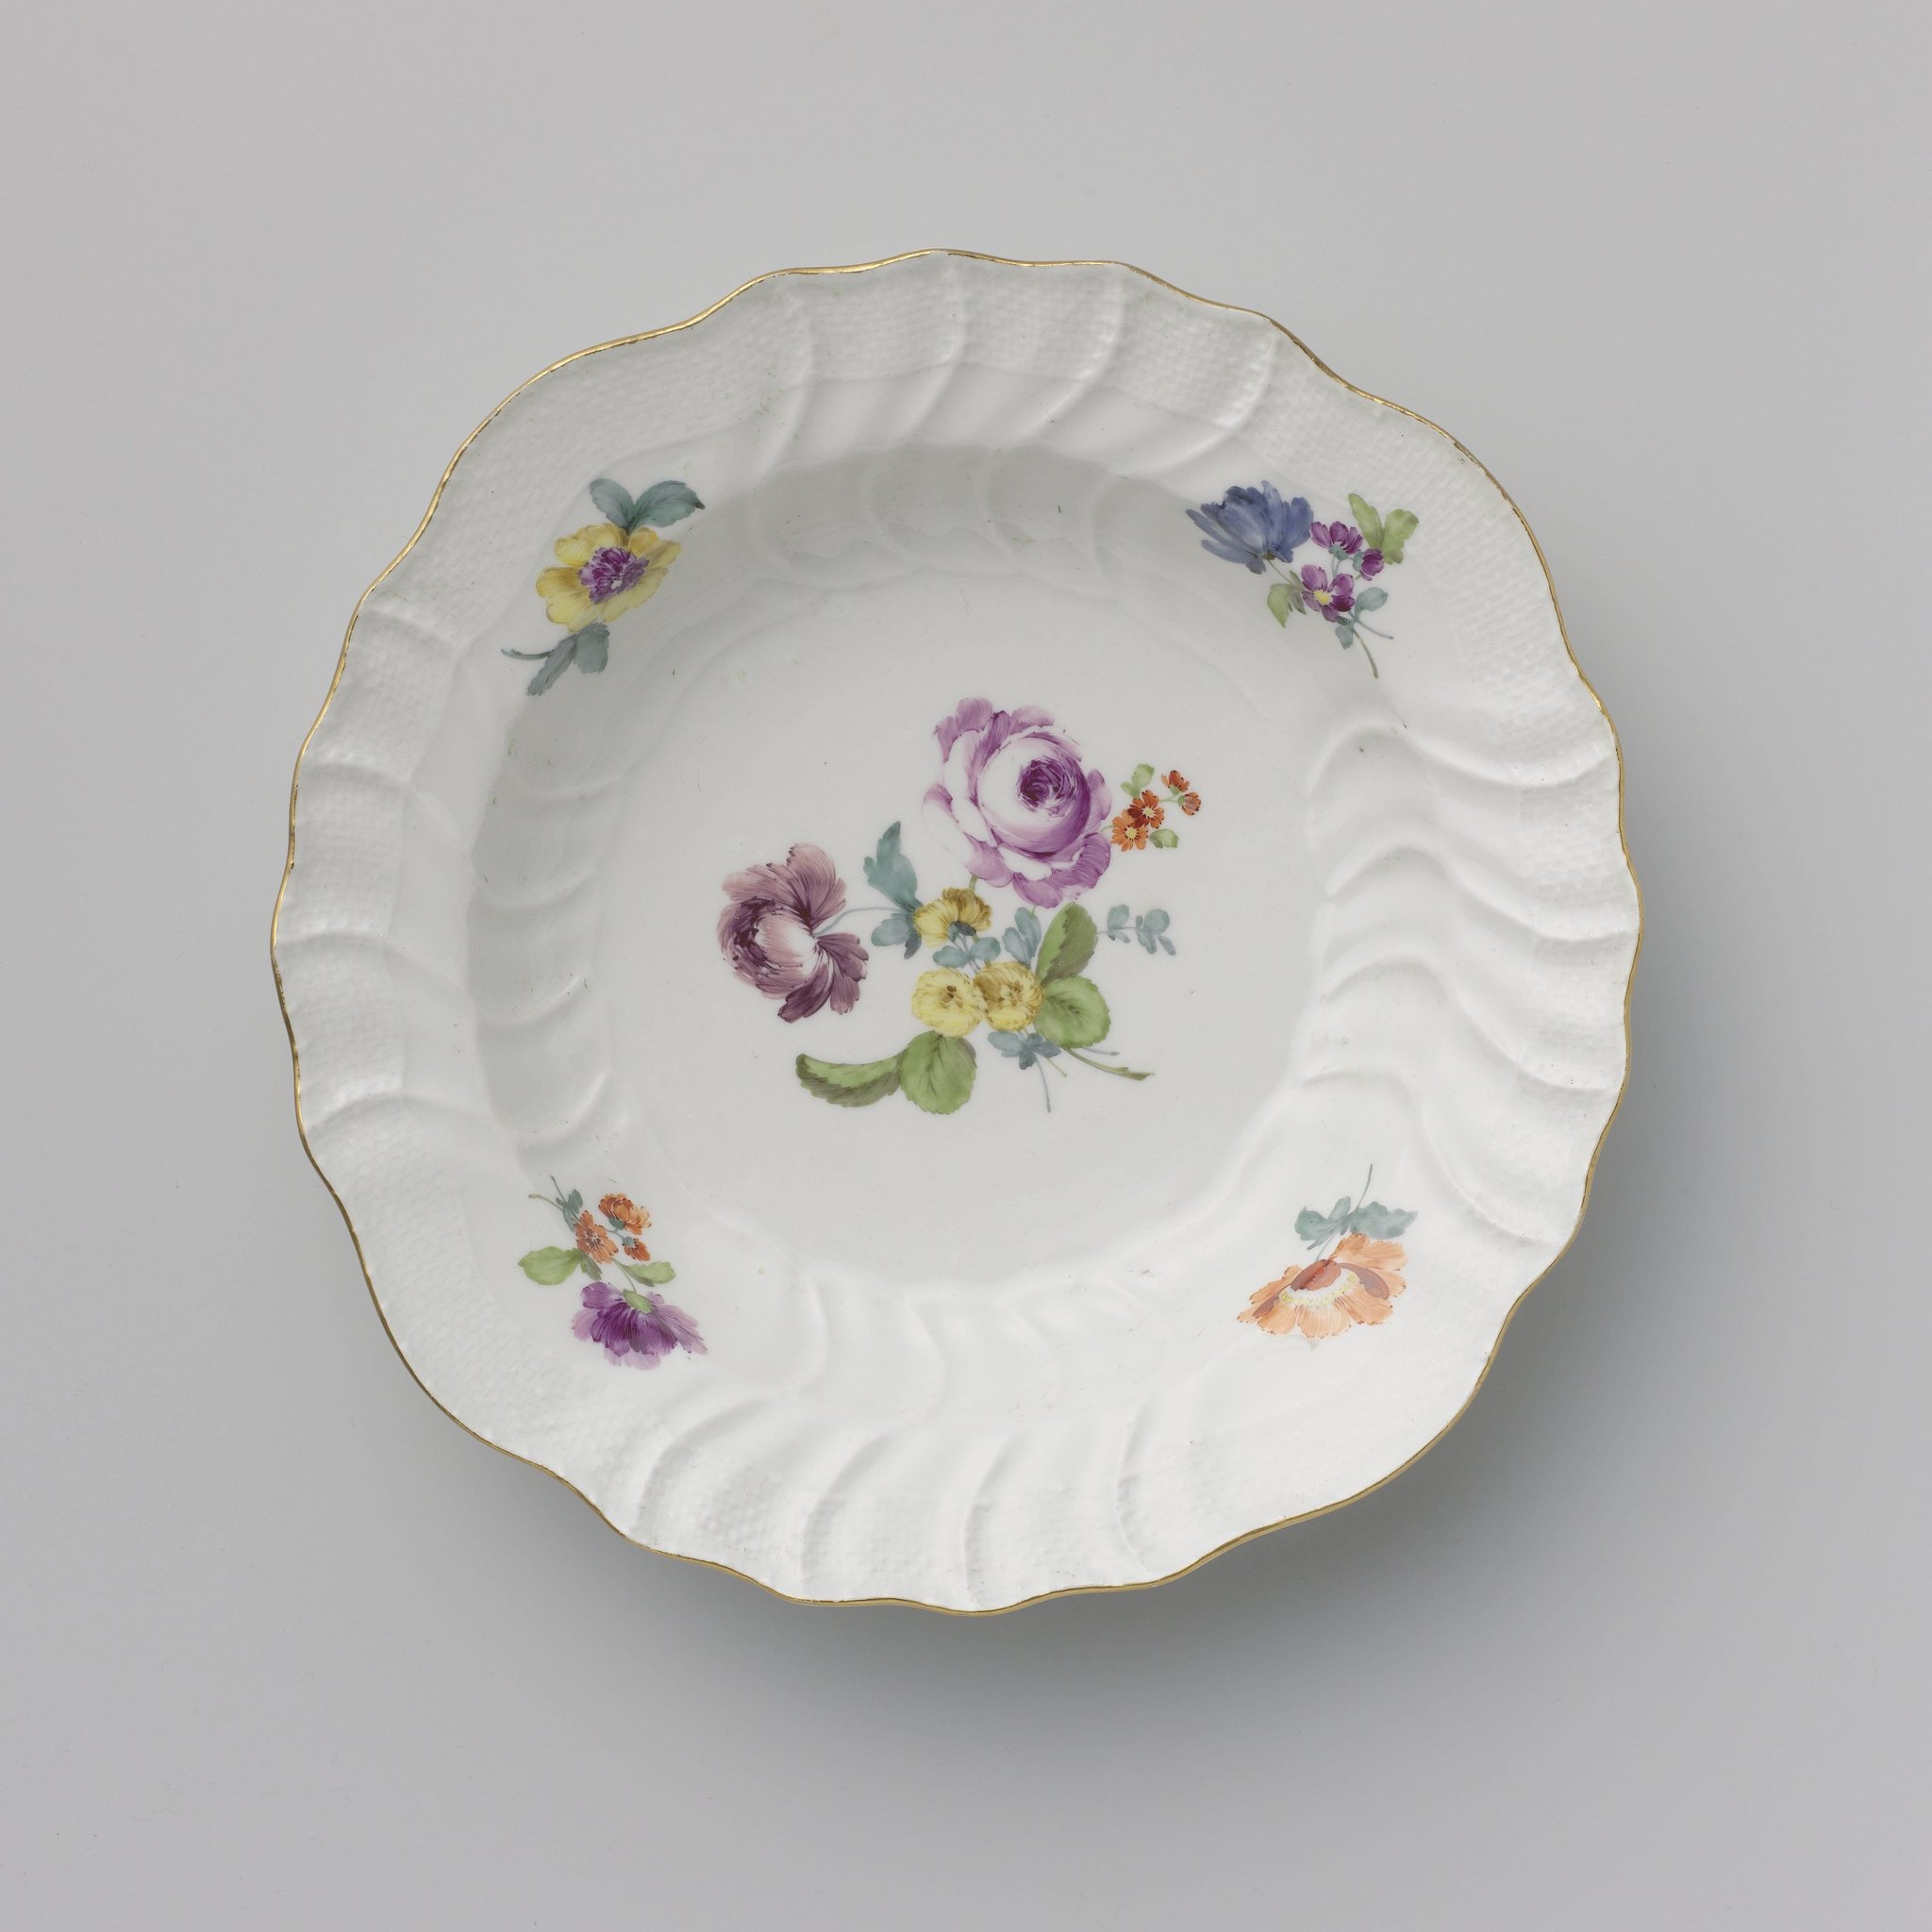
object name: eating drinking utensil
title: Bord, veelkleurig beschilderd met Deutsche Blumen, insekten en vruchten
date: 1750-1760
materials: porcelain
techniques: painted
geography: meissen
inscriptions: factory mark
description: Rond soepbord van beschilderd porselein. Het bord is beschilderd met Deutsche Blumen, insekten en vruchten. De rand is in reliëf versierd met het Neuozier-patroon. Het bord is gemerkt en hoort bij een servies (BK-17474-1 t/m BK-17474-253).